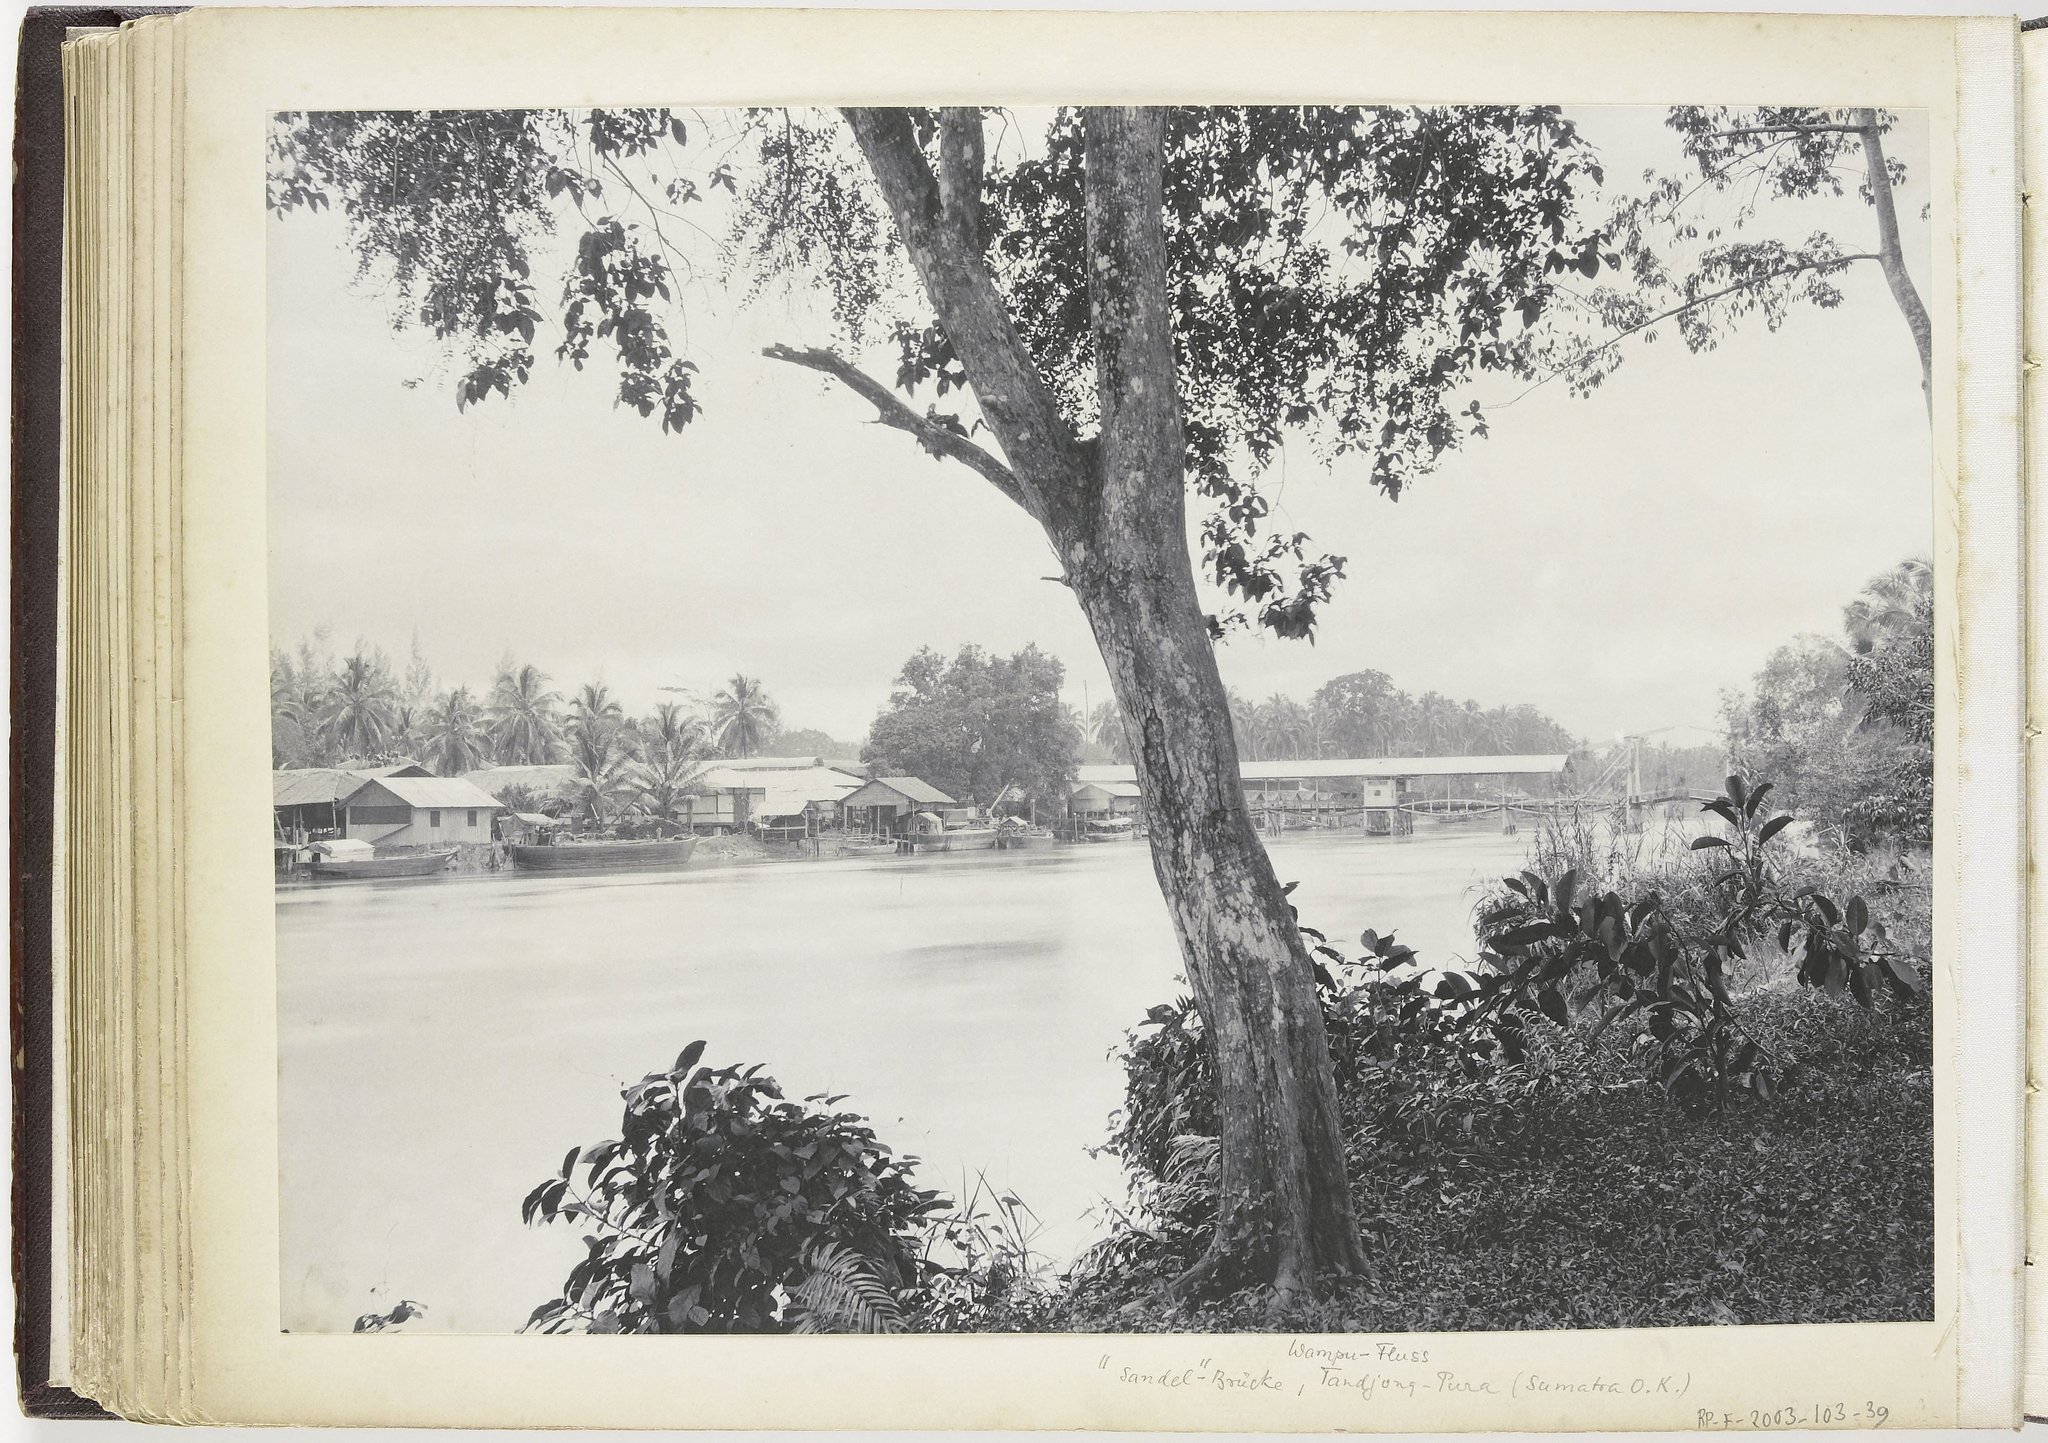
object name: photograph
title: Gezicht op Sandelbrug en werf aan de Wampoe-rivier, Tandjong Poera, Langkat Sumatra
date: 1900-1905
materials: cardboard, paper, photographic support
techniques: platinum process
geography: bindjai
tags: sumatra